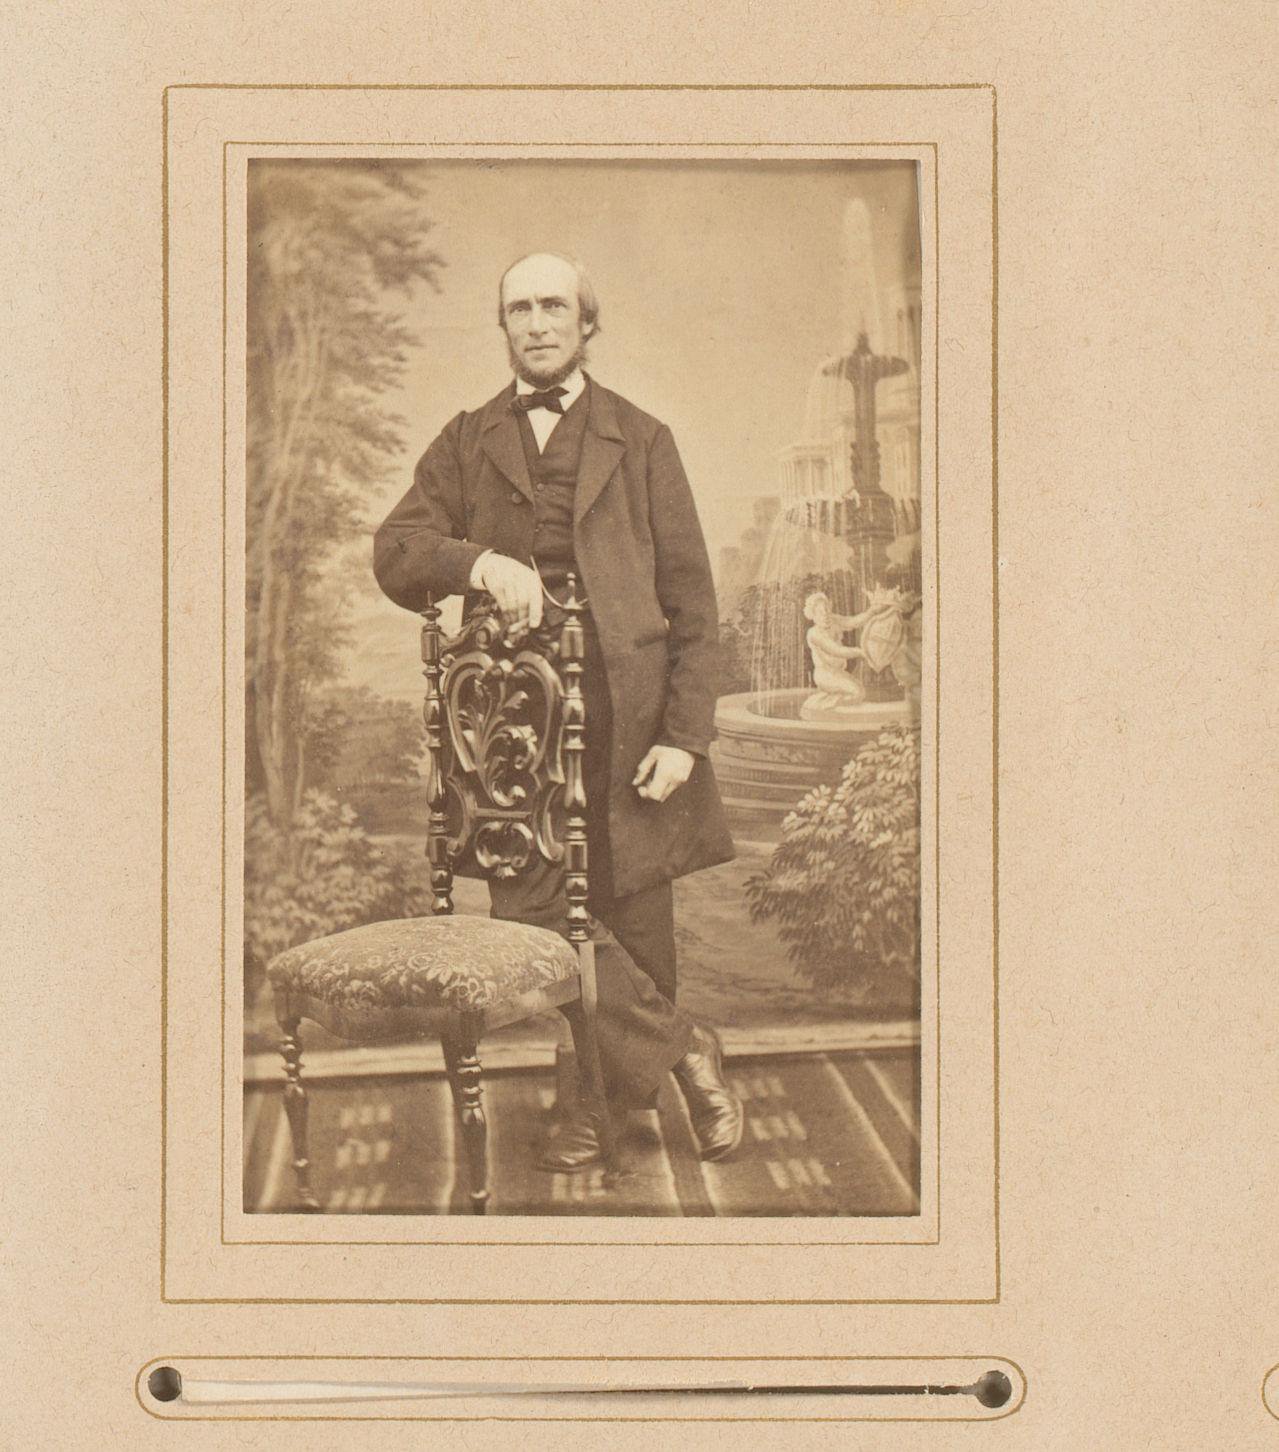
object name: carte de visite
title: Portret van een staande man bij een stoel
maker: h. jansen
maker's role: fotograaf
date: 1854-1858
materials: cardboard, photographic support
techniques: albumen print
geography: groningen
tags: historical persons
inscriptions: inscription: ‘H. Jansen’